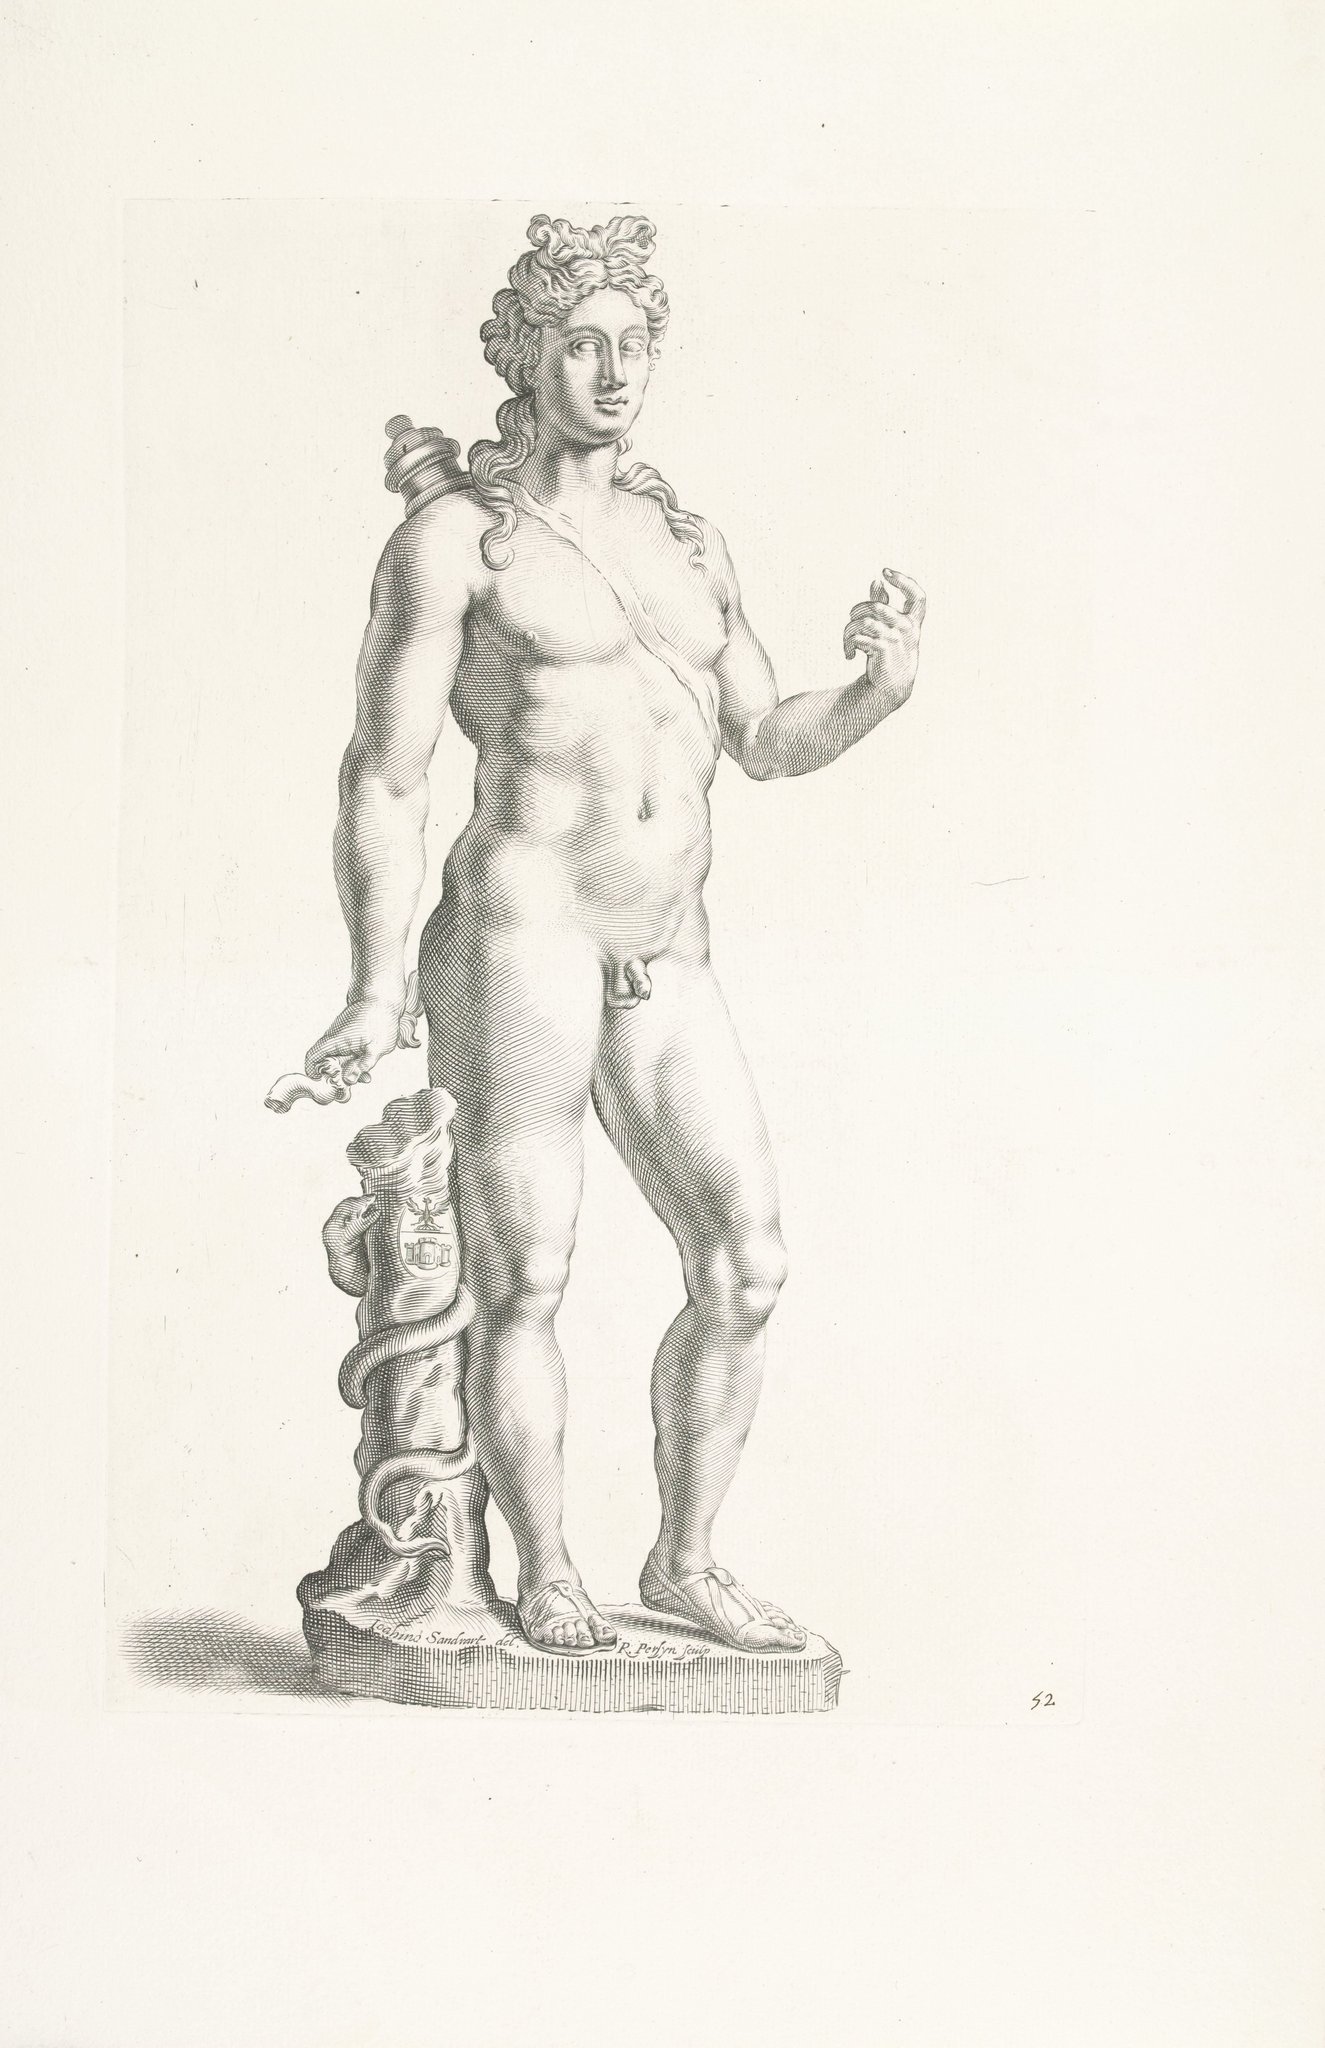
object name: print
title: Standbeeld van Apollo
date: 1640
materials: paper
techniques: engraving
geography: rome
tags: rome, vincenzo giustiniani (1564-1637), (story of) apollo (phoebus), piece of sculpture, reproduction of a piece of sculpture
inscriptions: collector's mark: Lugt 2228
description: Standbeeld van Apollo, met een pijlenkoker op de rug. Een python kronkelt naast hem. Boven aan de boomstam het wapenschild van Vincenzo Giustiniani. Prent uit een publicatie met reproductieprenten naar de sculpturen in de verzameling in de Galleria Giustiniani te Rome.